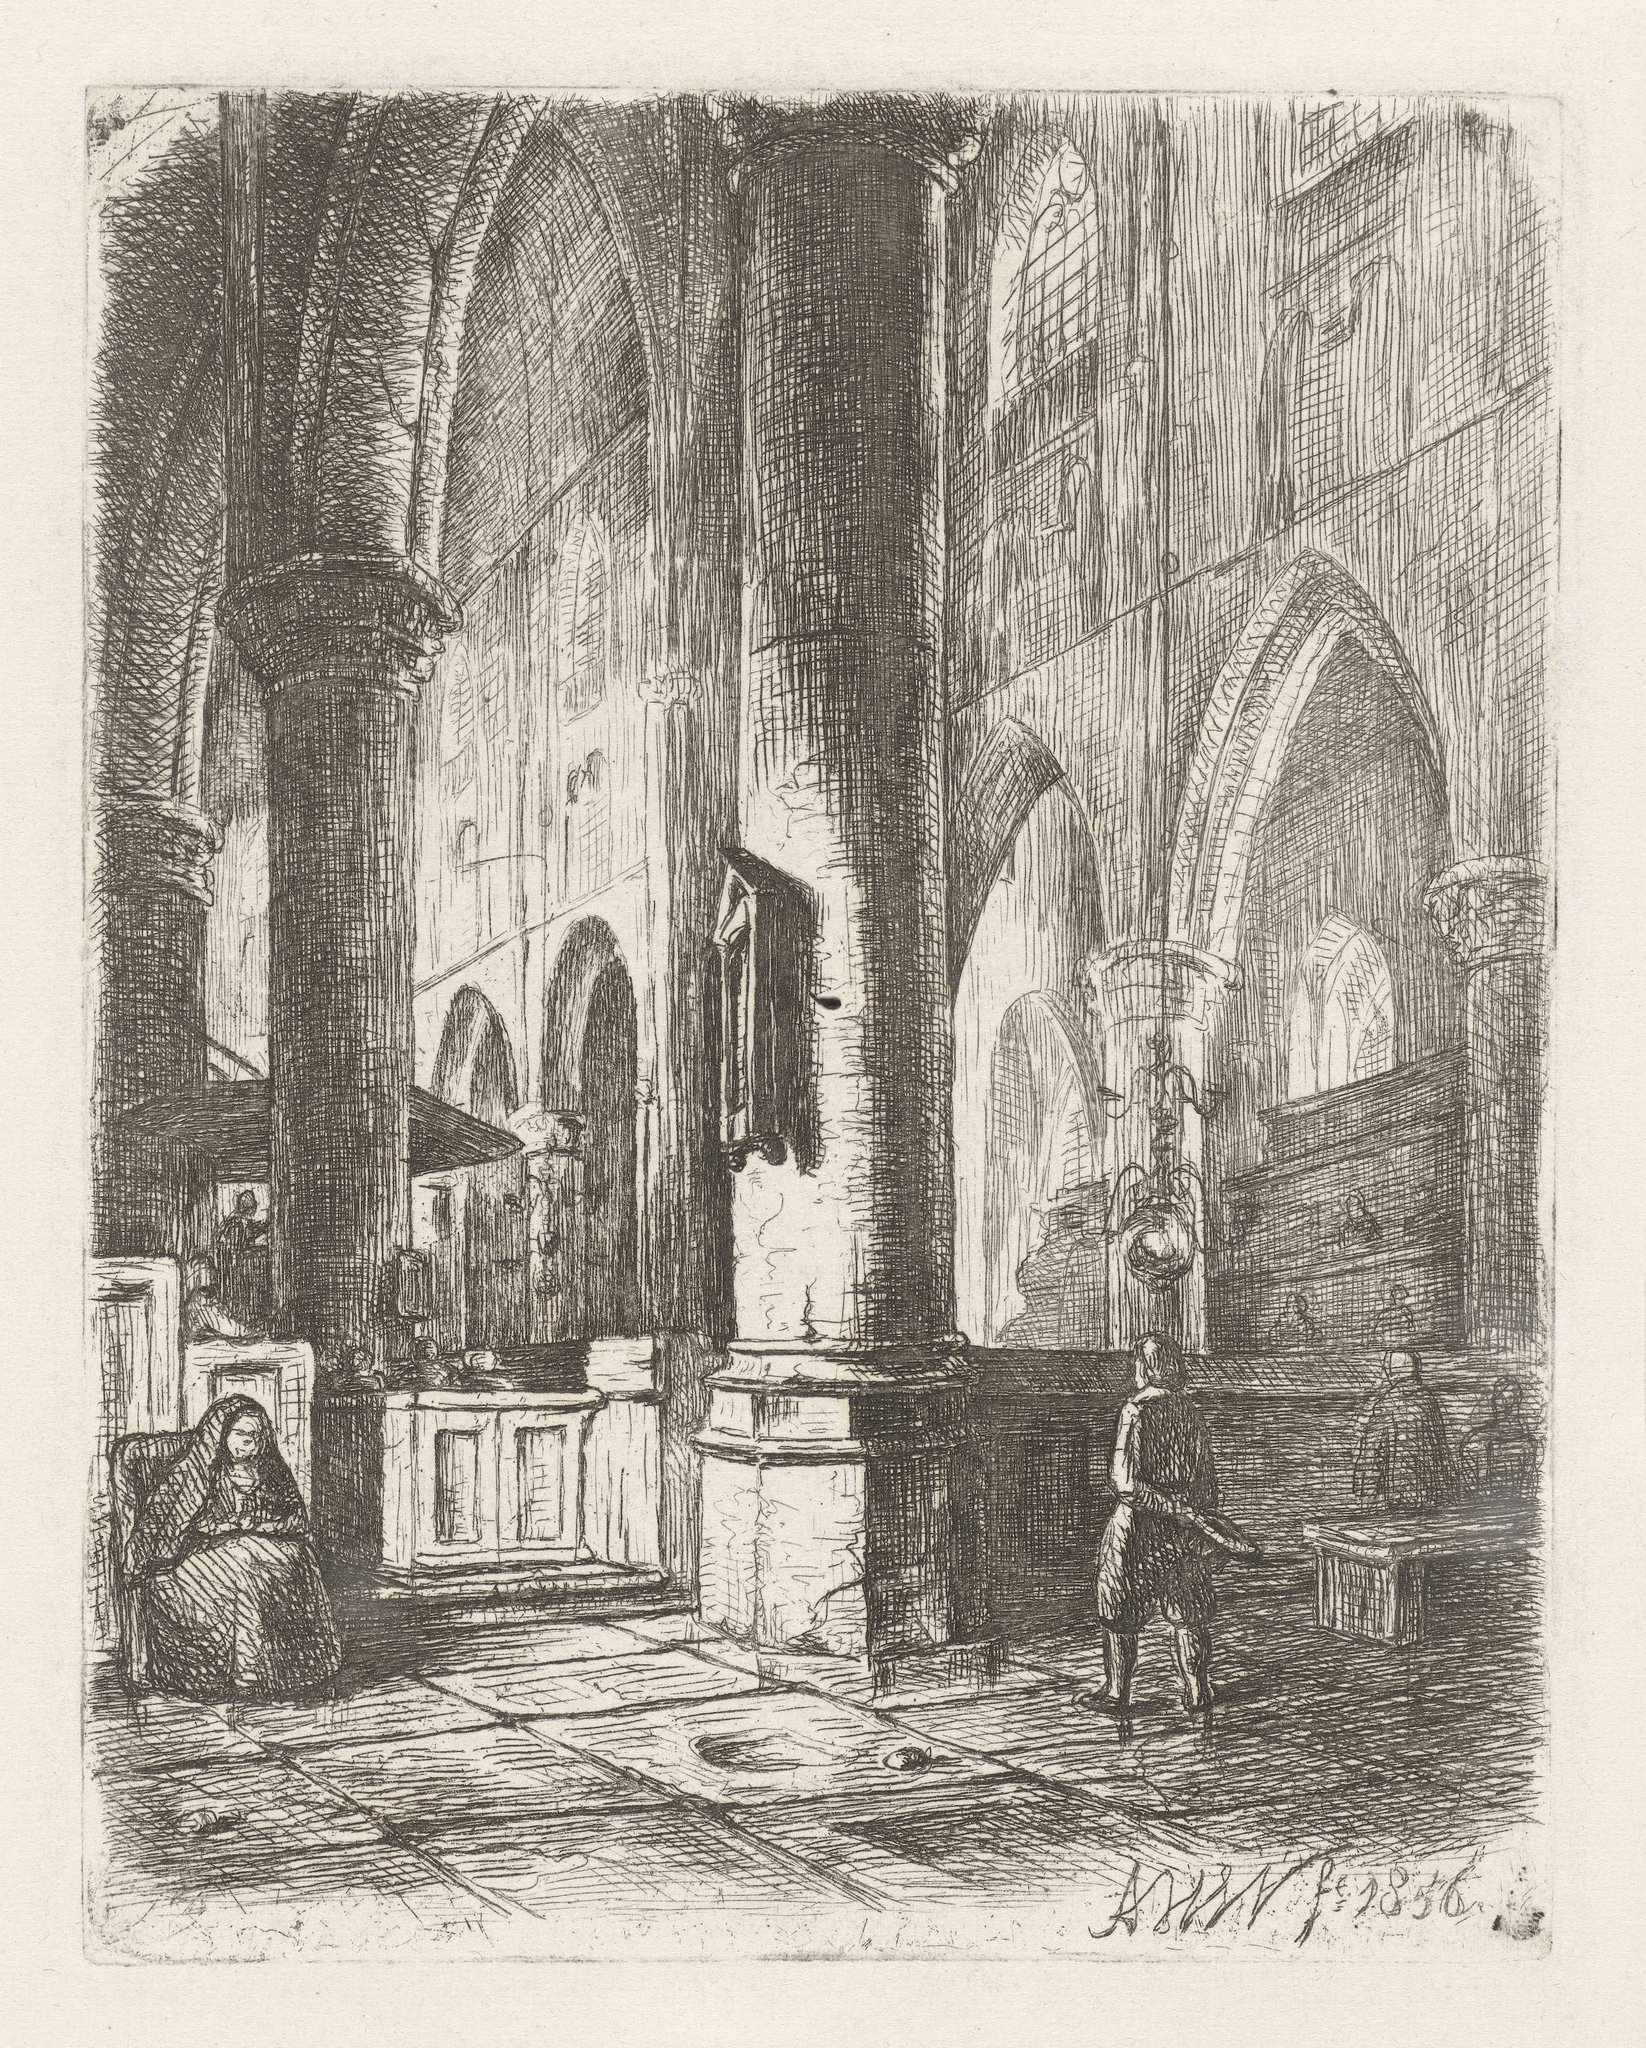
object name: print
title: Kerkinterieur met een jongen en een zittende vrouw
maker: adrianus wilhelmus nieuwenhuyzen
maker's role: draughtsman, print maker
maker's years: 1814-1894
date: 1856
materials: paper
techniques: etching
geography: utrecht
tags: interior of church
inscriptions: collector's mark: Lugt 2228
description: Kerkinterieur links een zittende vrouw en rechts een jongen op de rug gezien. De jongen heeft zijn hoed afgenomen.